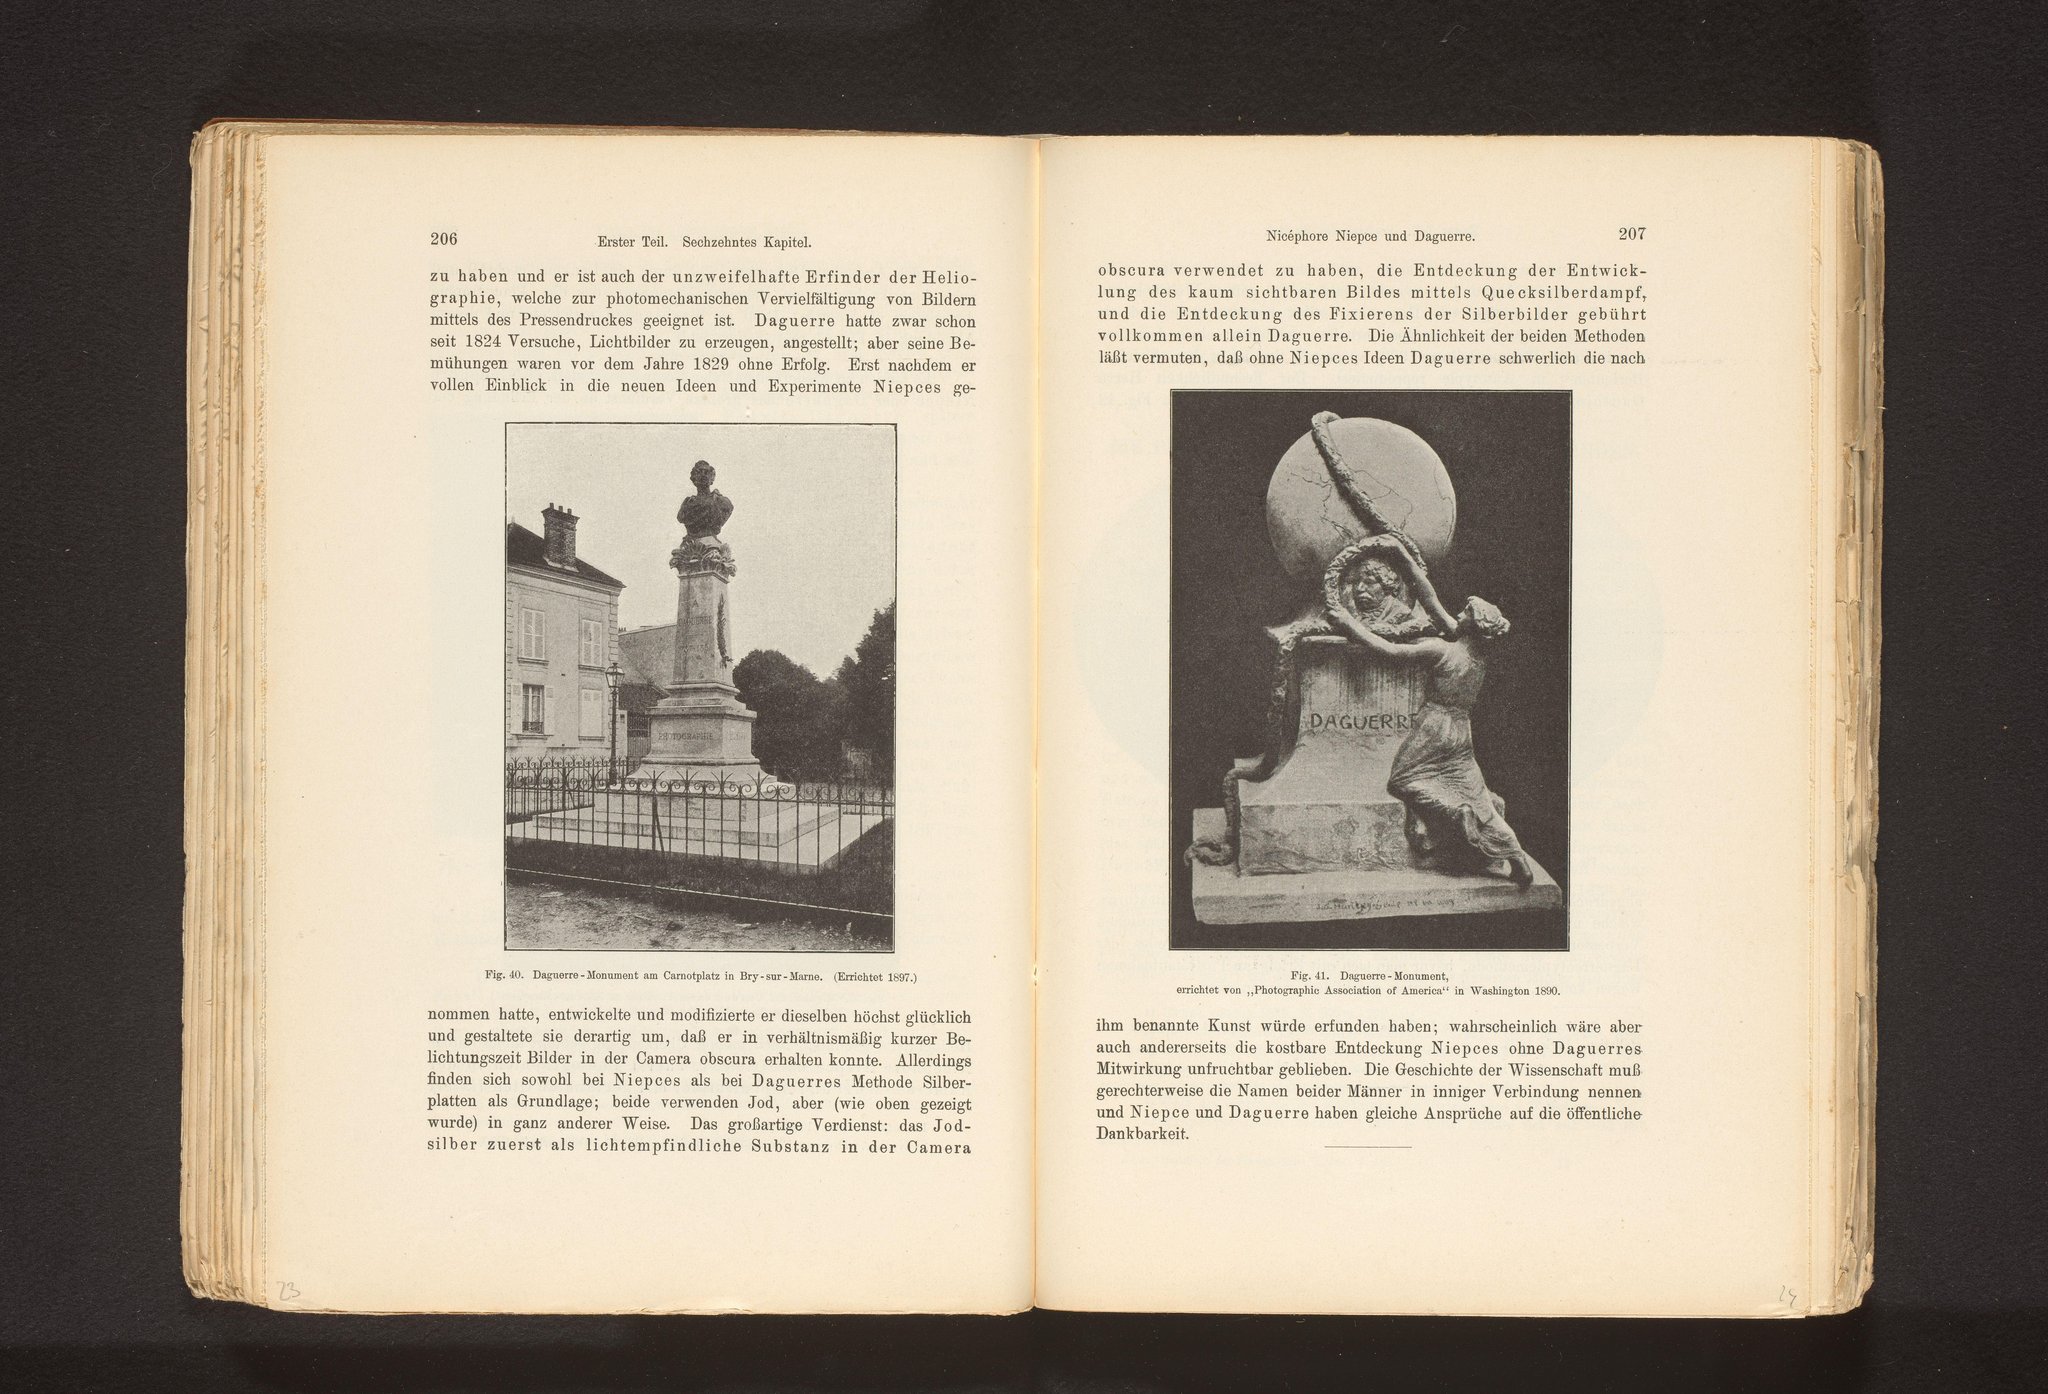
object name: photomechanical print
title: Monument voor Louis Daguerre te Washington D. C.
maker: Anonymous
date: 1900-1905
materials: paper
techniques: autotype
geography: washington d.c.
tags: monument, statue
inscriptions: number: ‘Fig. 41.’